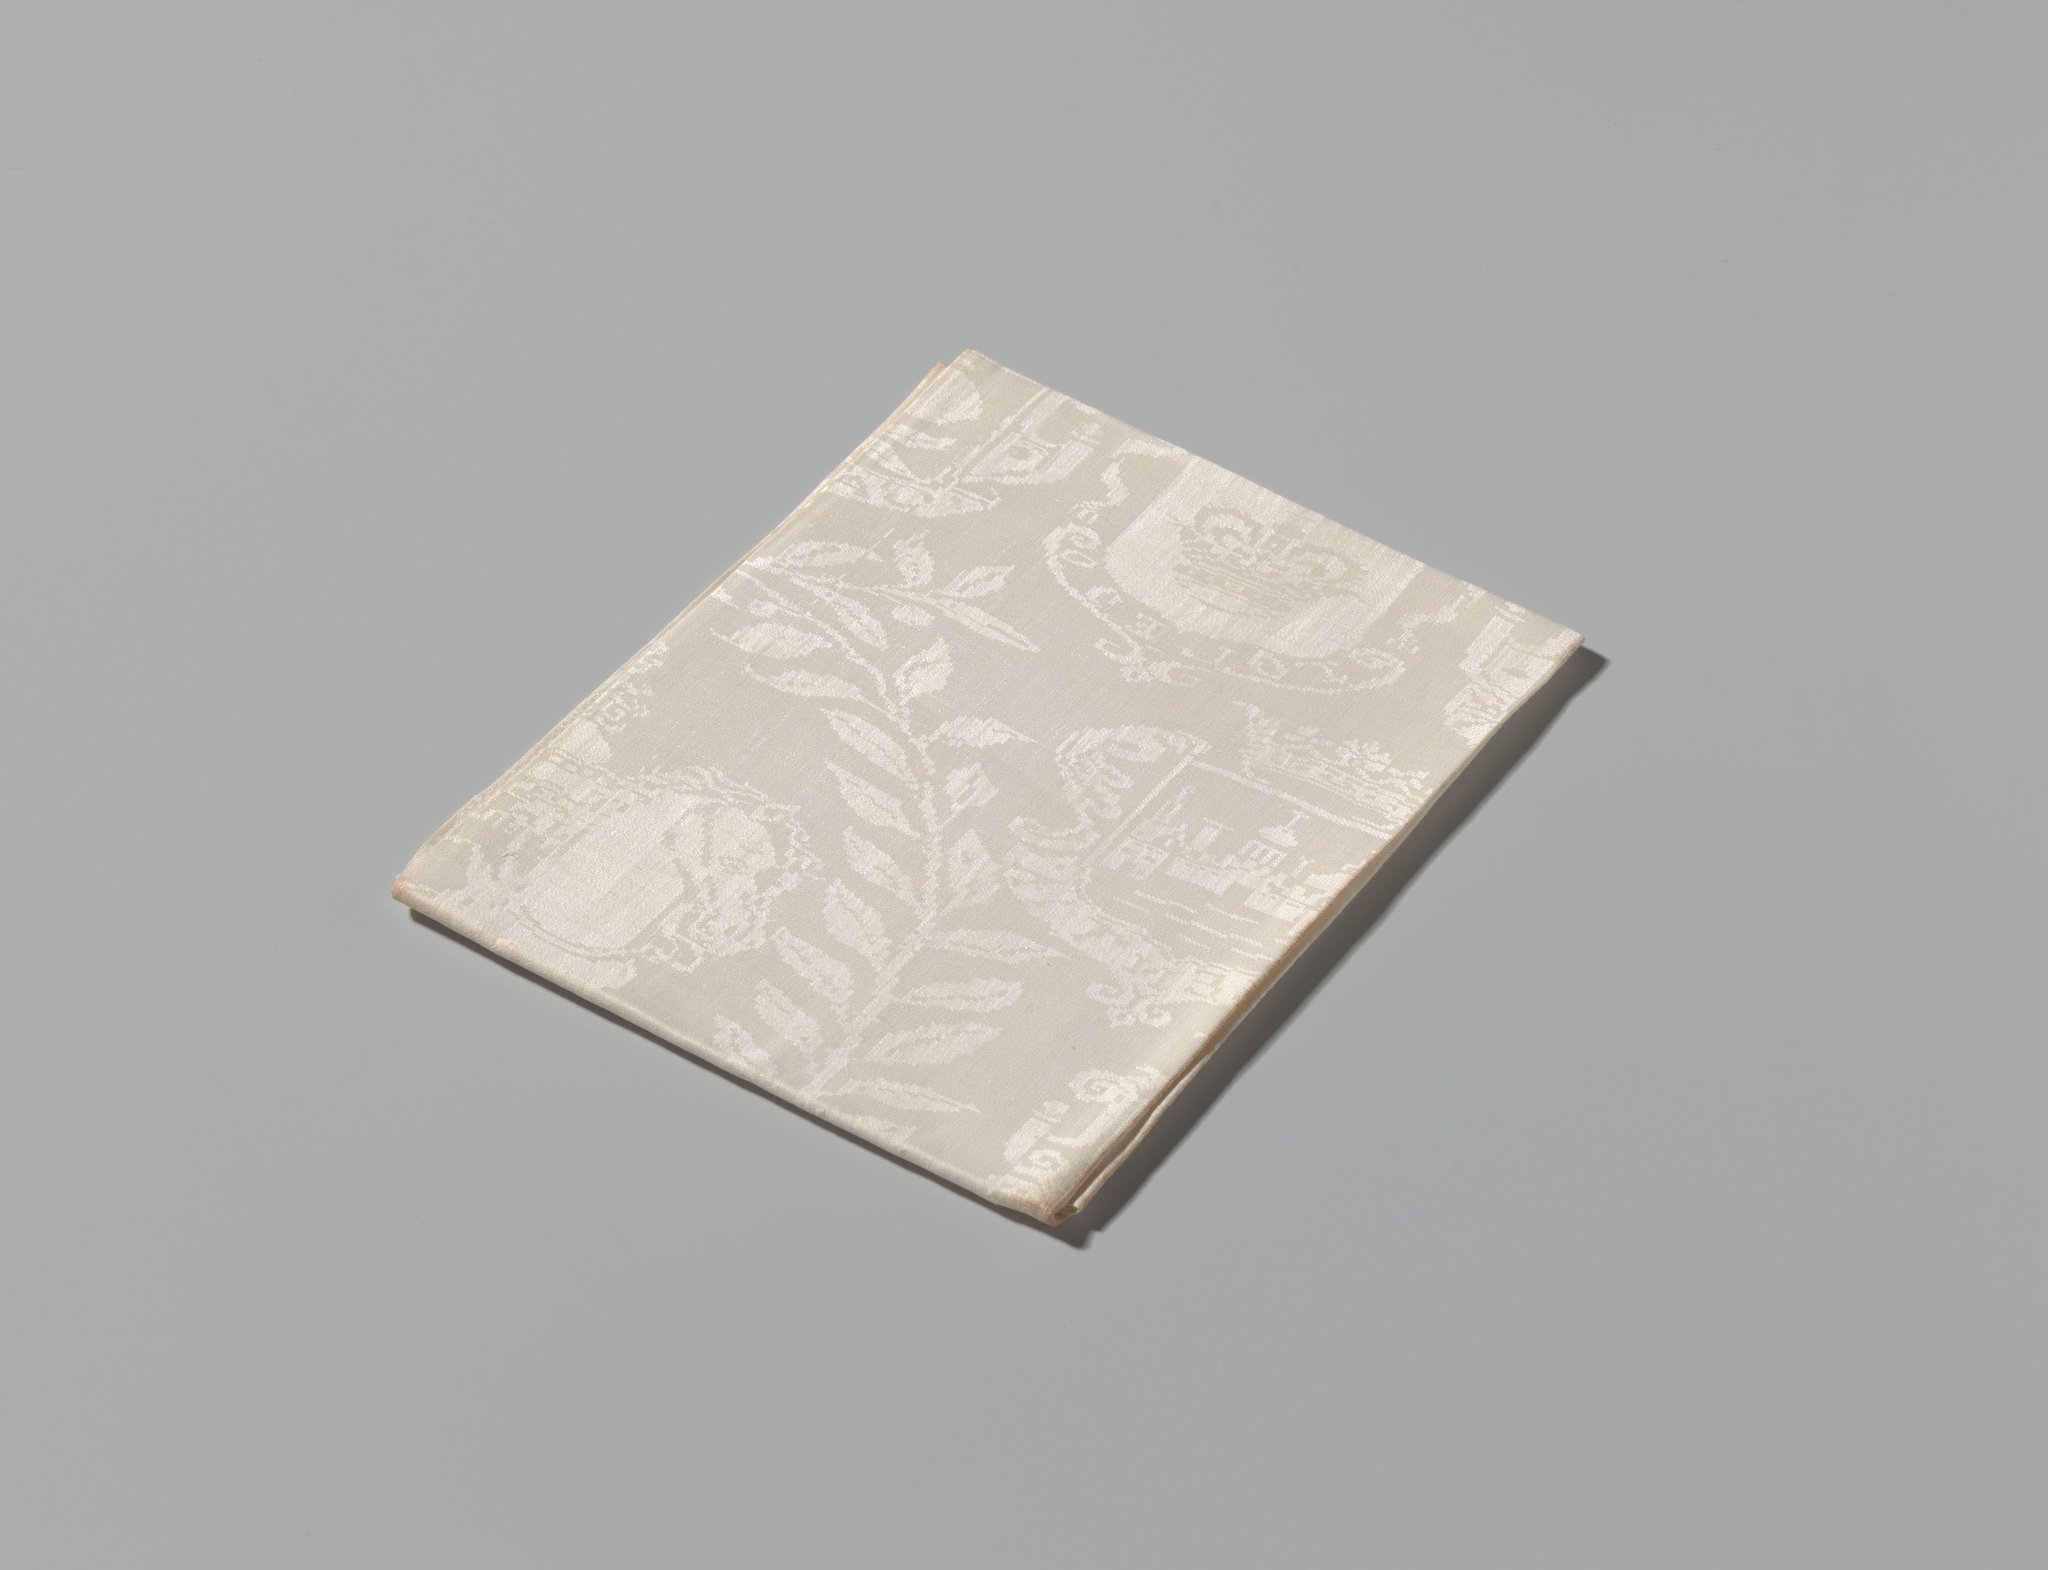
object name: napkin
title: Servet met een hommage aan de pretendent van de Spaanse kroon Karel van Habsburg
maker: Anonymous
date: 1707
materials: linen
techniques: damask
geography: flanders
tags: vienna, charles vi (holy roman emperor)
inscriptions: mark: ‘dBP 12’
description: Wit linnen damasten servet met hommage aan de pretendent van de Spaanse kroon met het inschrift "VIVE HISPANIARVM REX", daaromheen gekroonde wapenschilden met vijftien Spaanse provinciewapens en -namen "CICILIAS", "CASTIL", "ARAGON", "NAVAR", "TOLEDO", "GRANADA", "VALENCIA", "GALICI", "MALLORCAS", "CORDV", "CERDENA", "MVRCIA", "CORSA" en "IANEN", "ANNO 1707", gemerkt dBP 12.